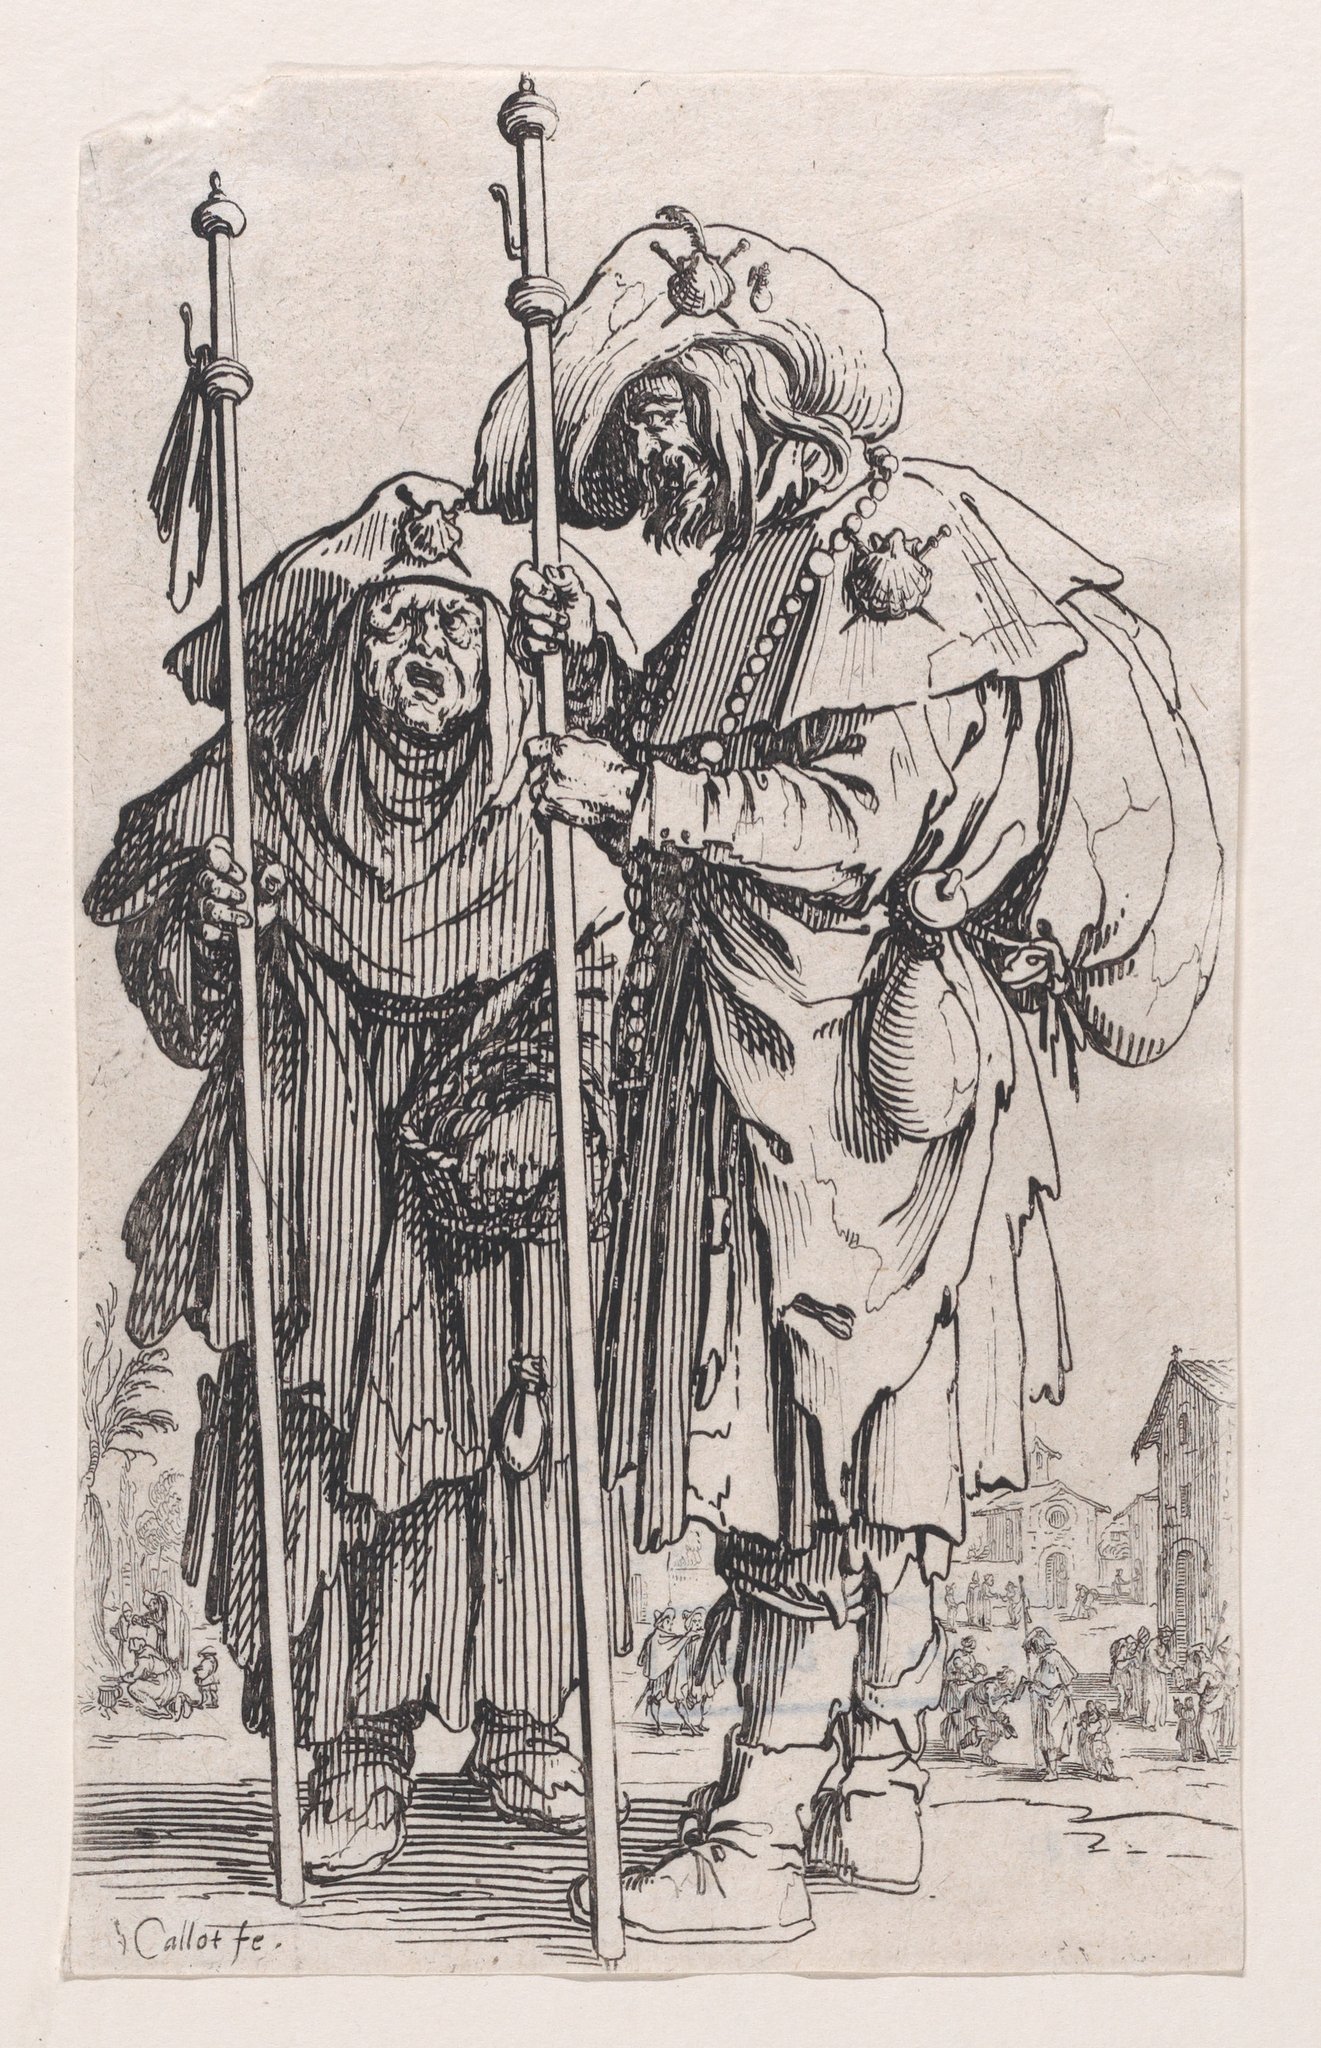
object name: print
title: Les Deux Pélerins (The Two Pilgrims), from "Les Gueux suite appelée aussi Les Mendiants, Les Baroni, ou Les Barons" (The Beggars, also called the Barons)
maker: jacques callot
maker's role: artist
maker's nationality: french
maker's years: 1592-1635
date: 1623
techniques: etching